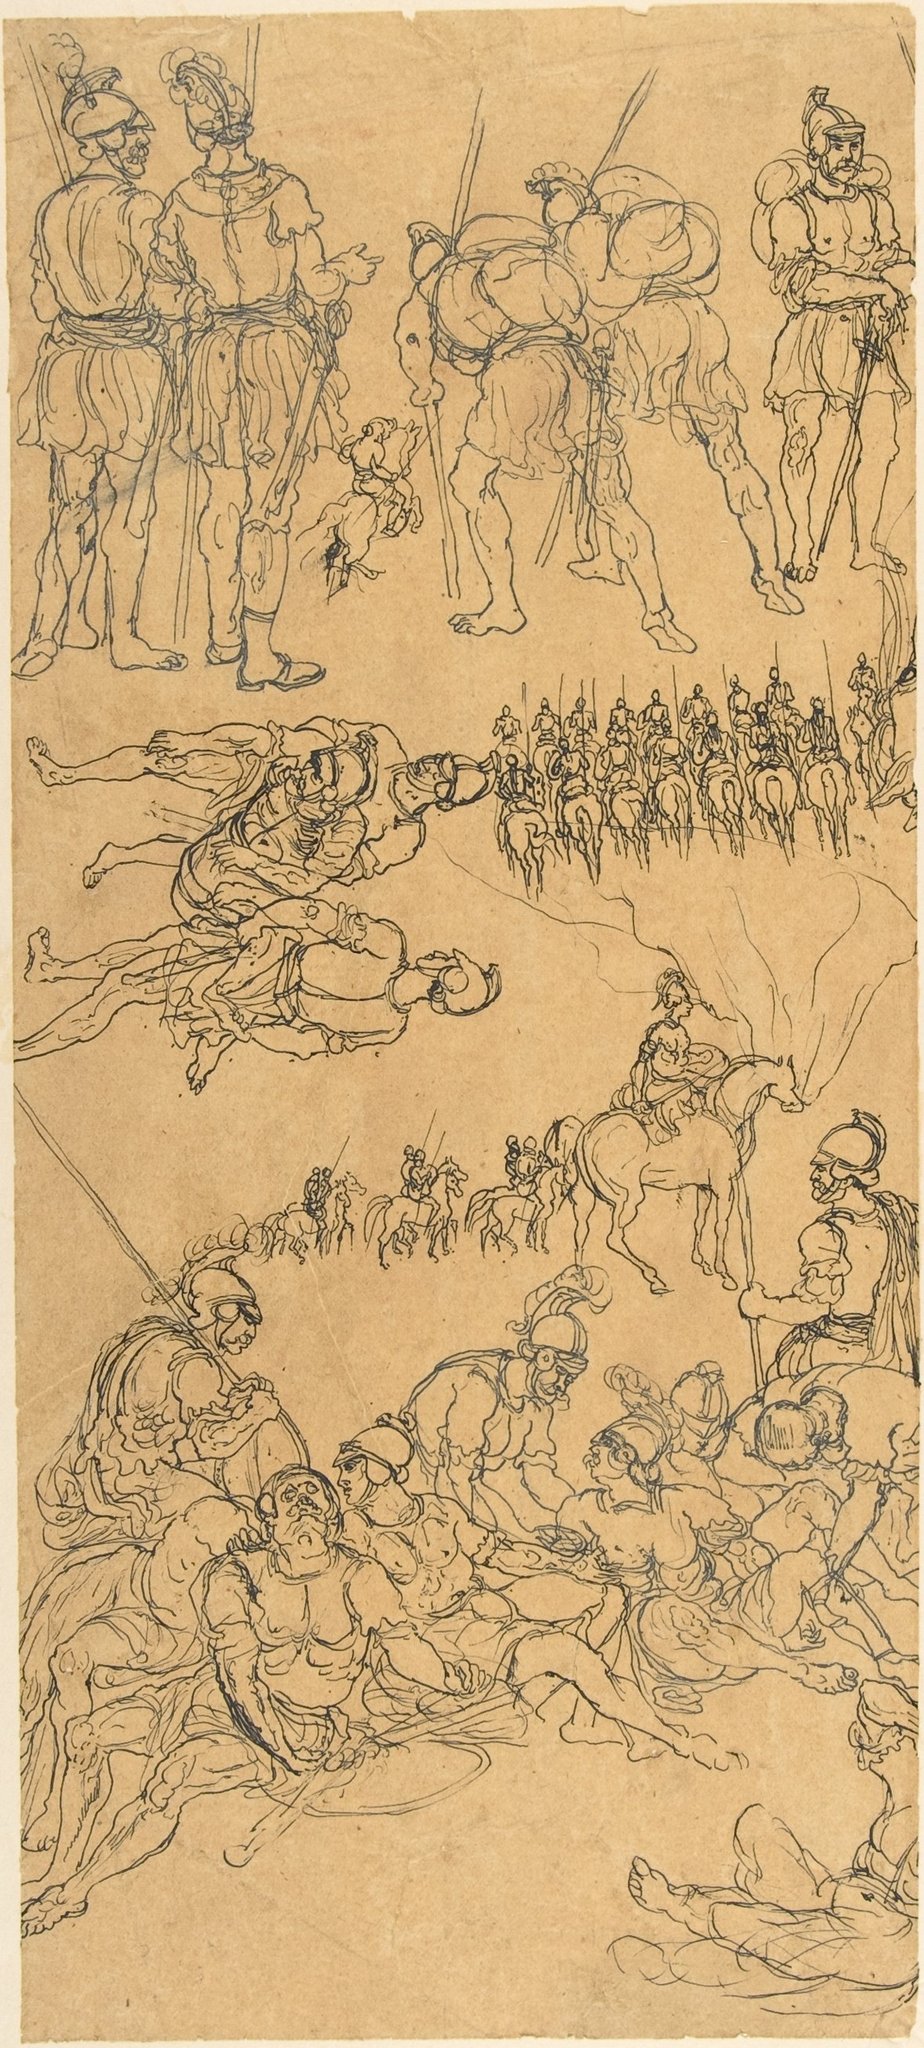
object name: drawing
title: Sketches of Roman Soldiers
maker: rodolphe bresdin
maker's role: artist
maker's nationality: french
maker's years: 1822-1885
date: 1842-1885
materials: ink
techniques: pen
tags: soldiers,weapons,horses